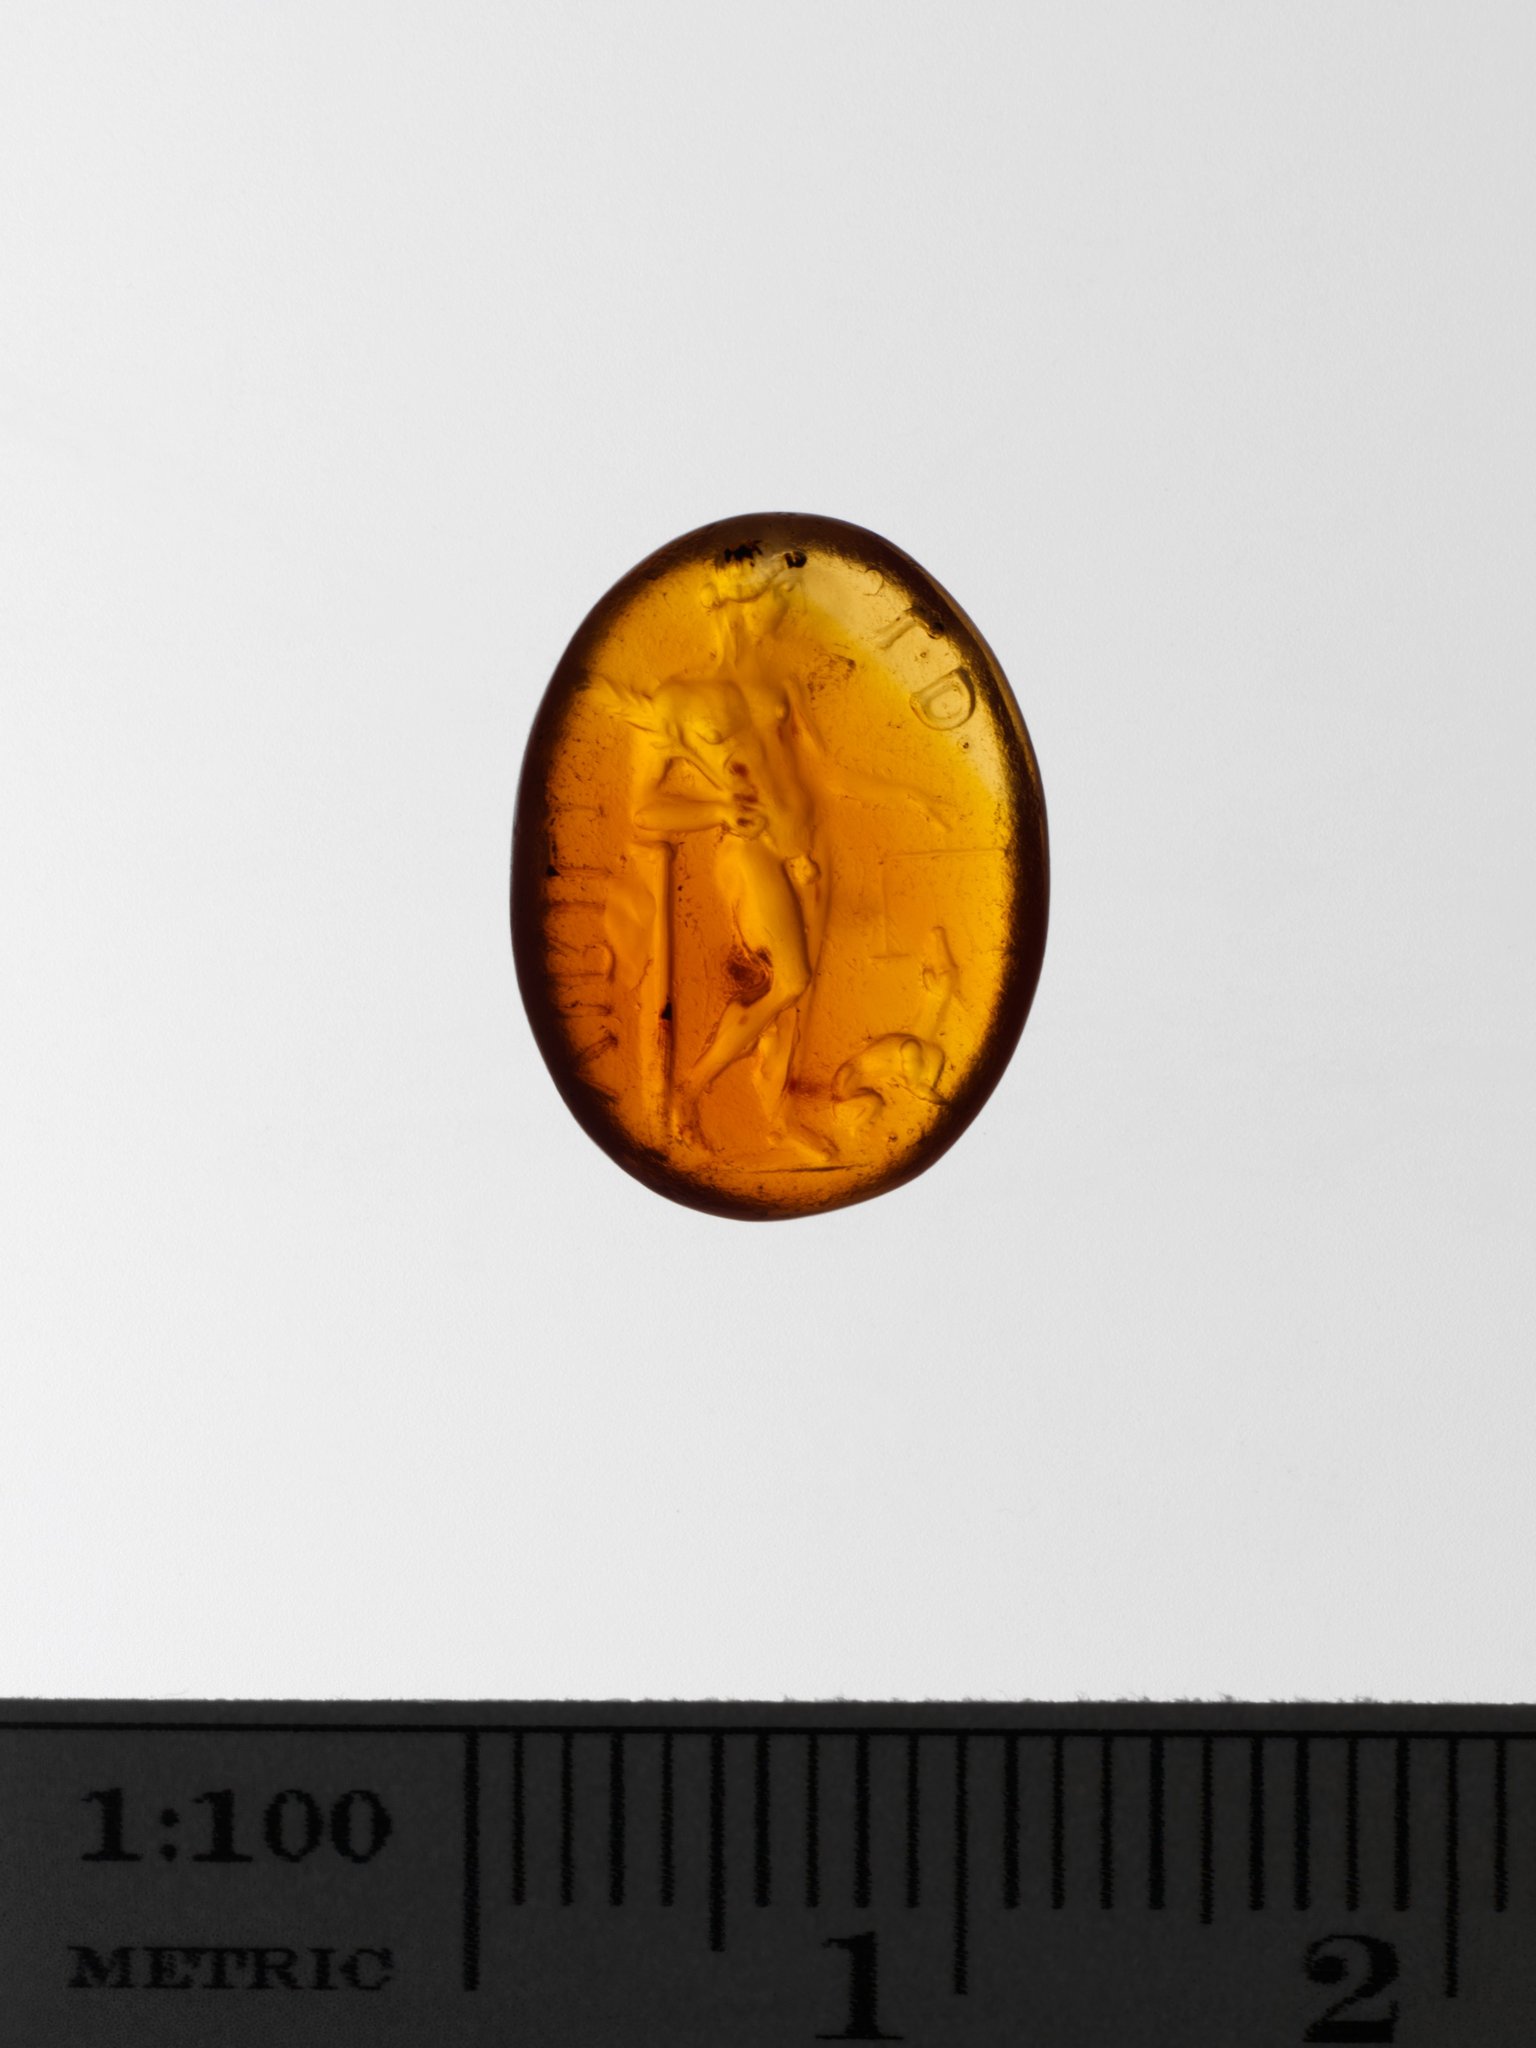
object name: intaglio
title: Sard ring stone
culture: roman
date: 1-100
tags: male nudes,dogs